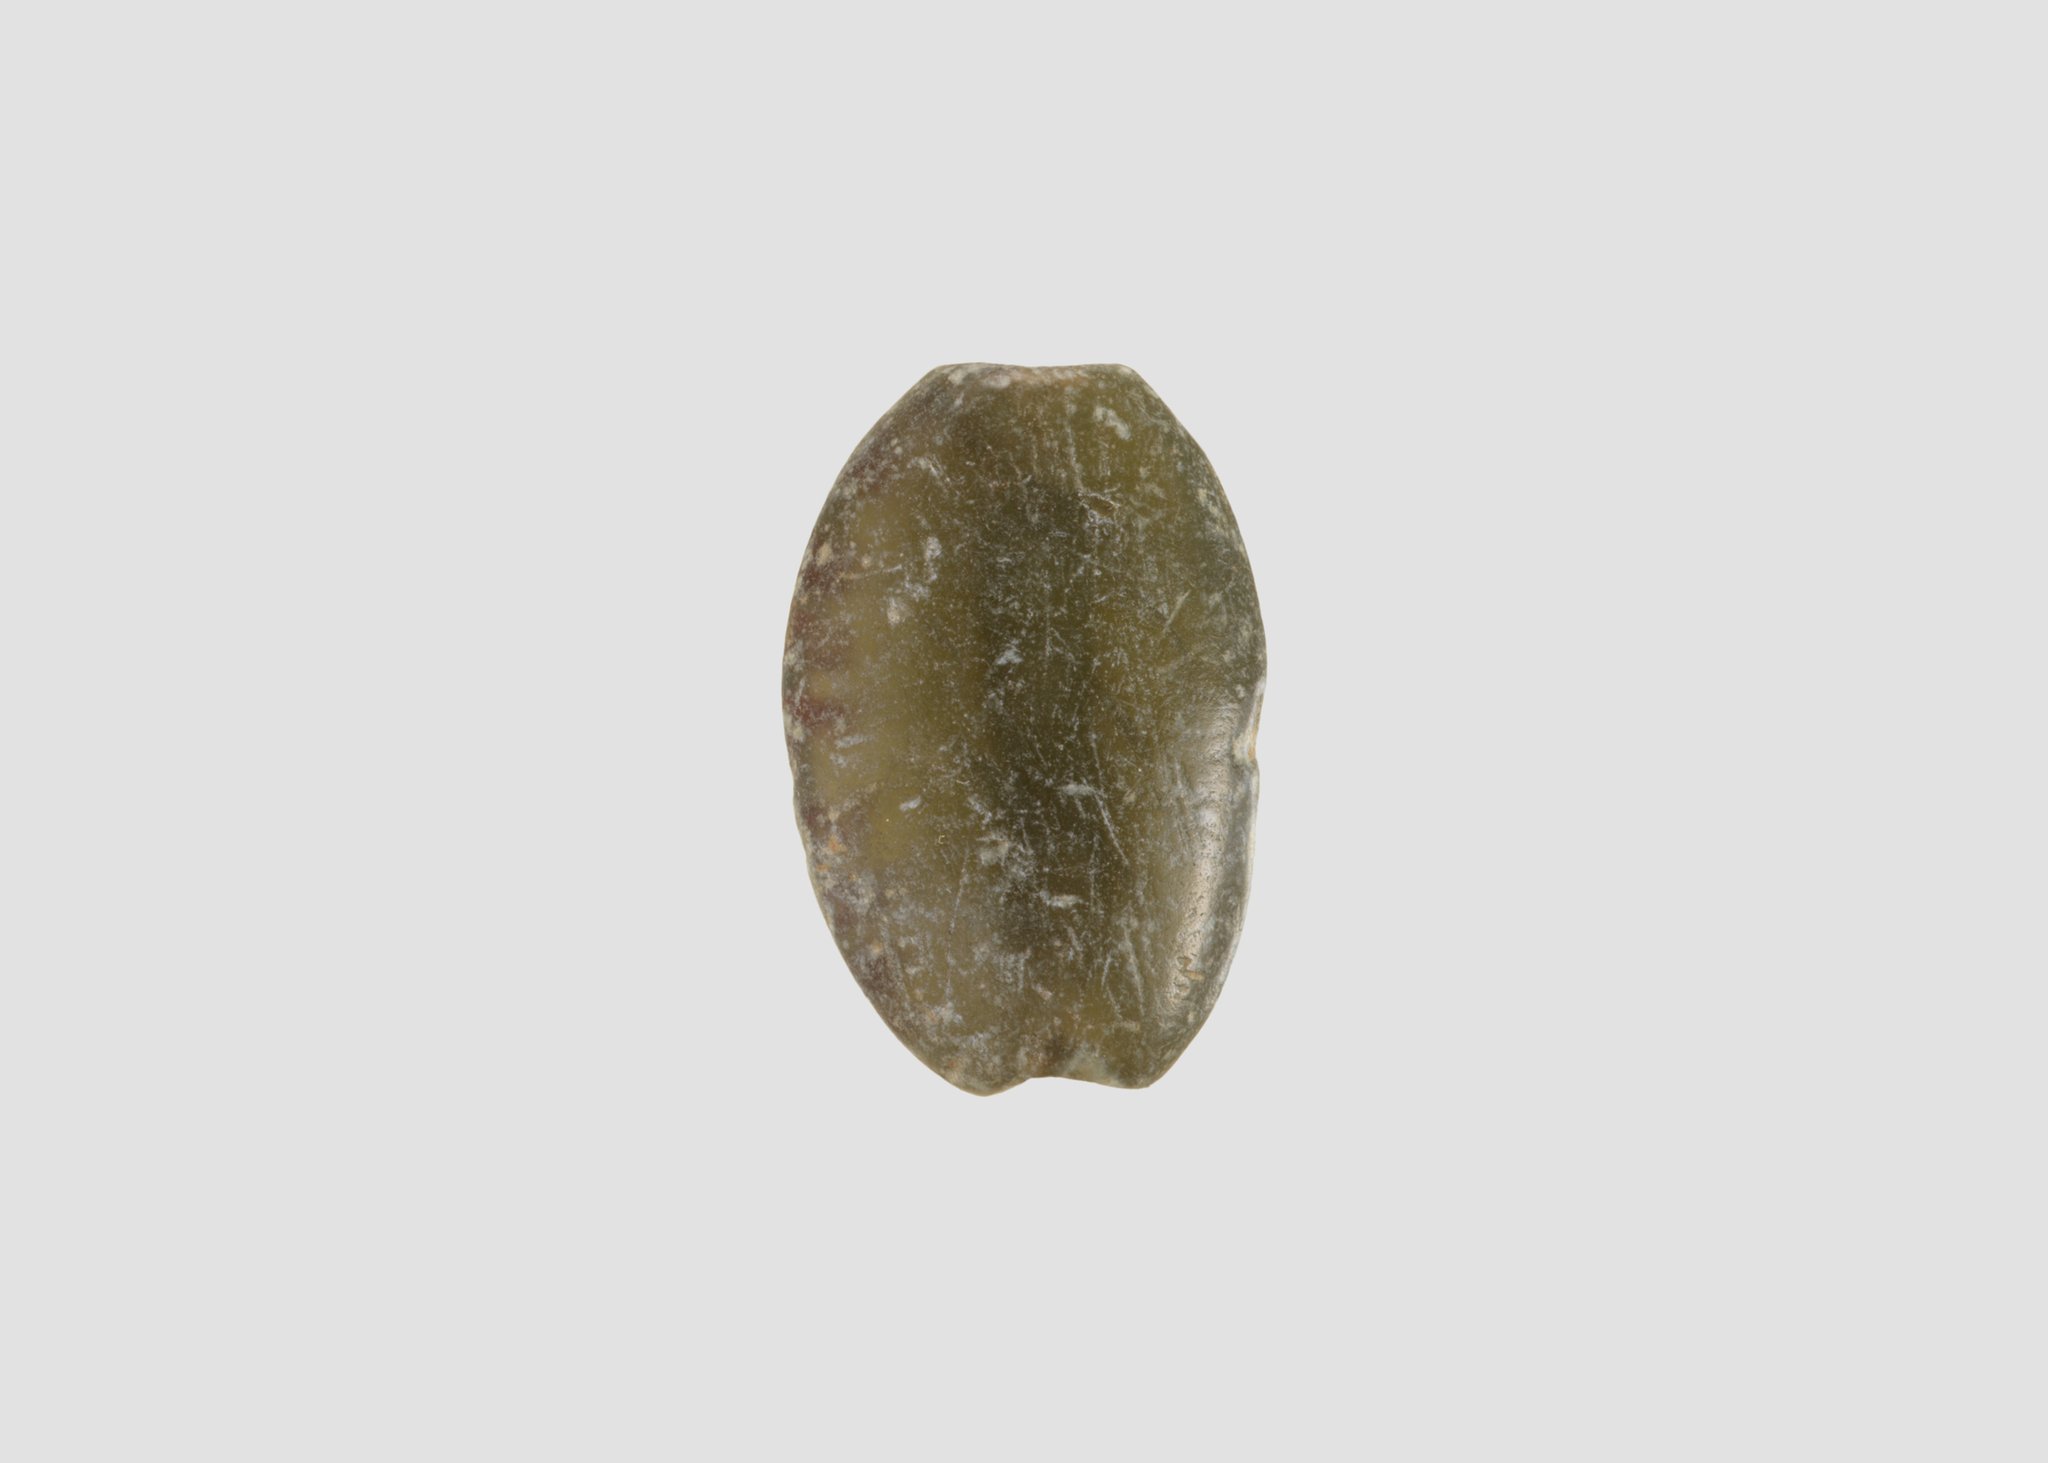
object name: bead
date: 7000-5001 BCE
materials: mineral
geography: syria